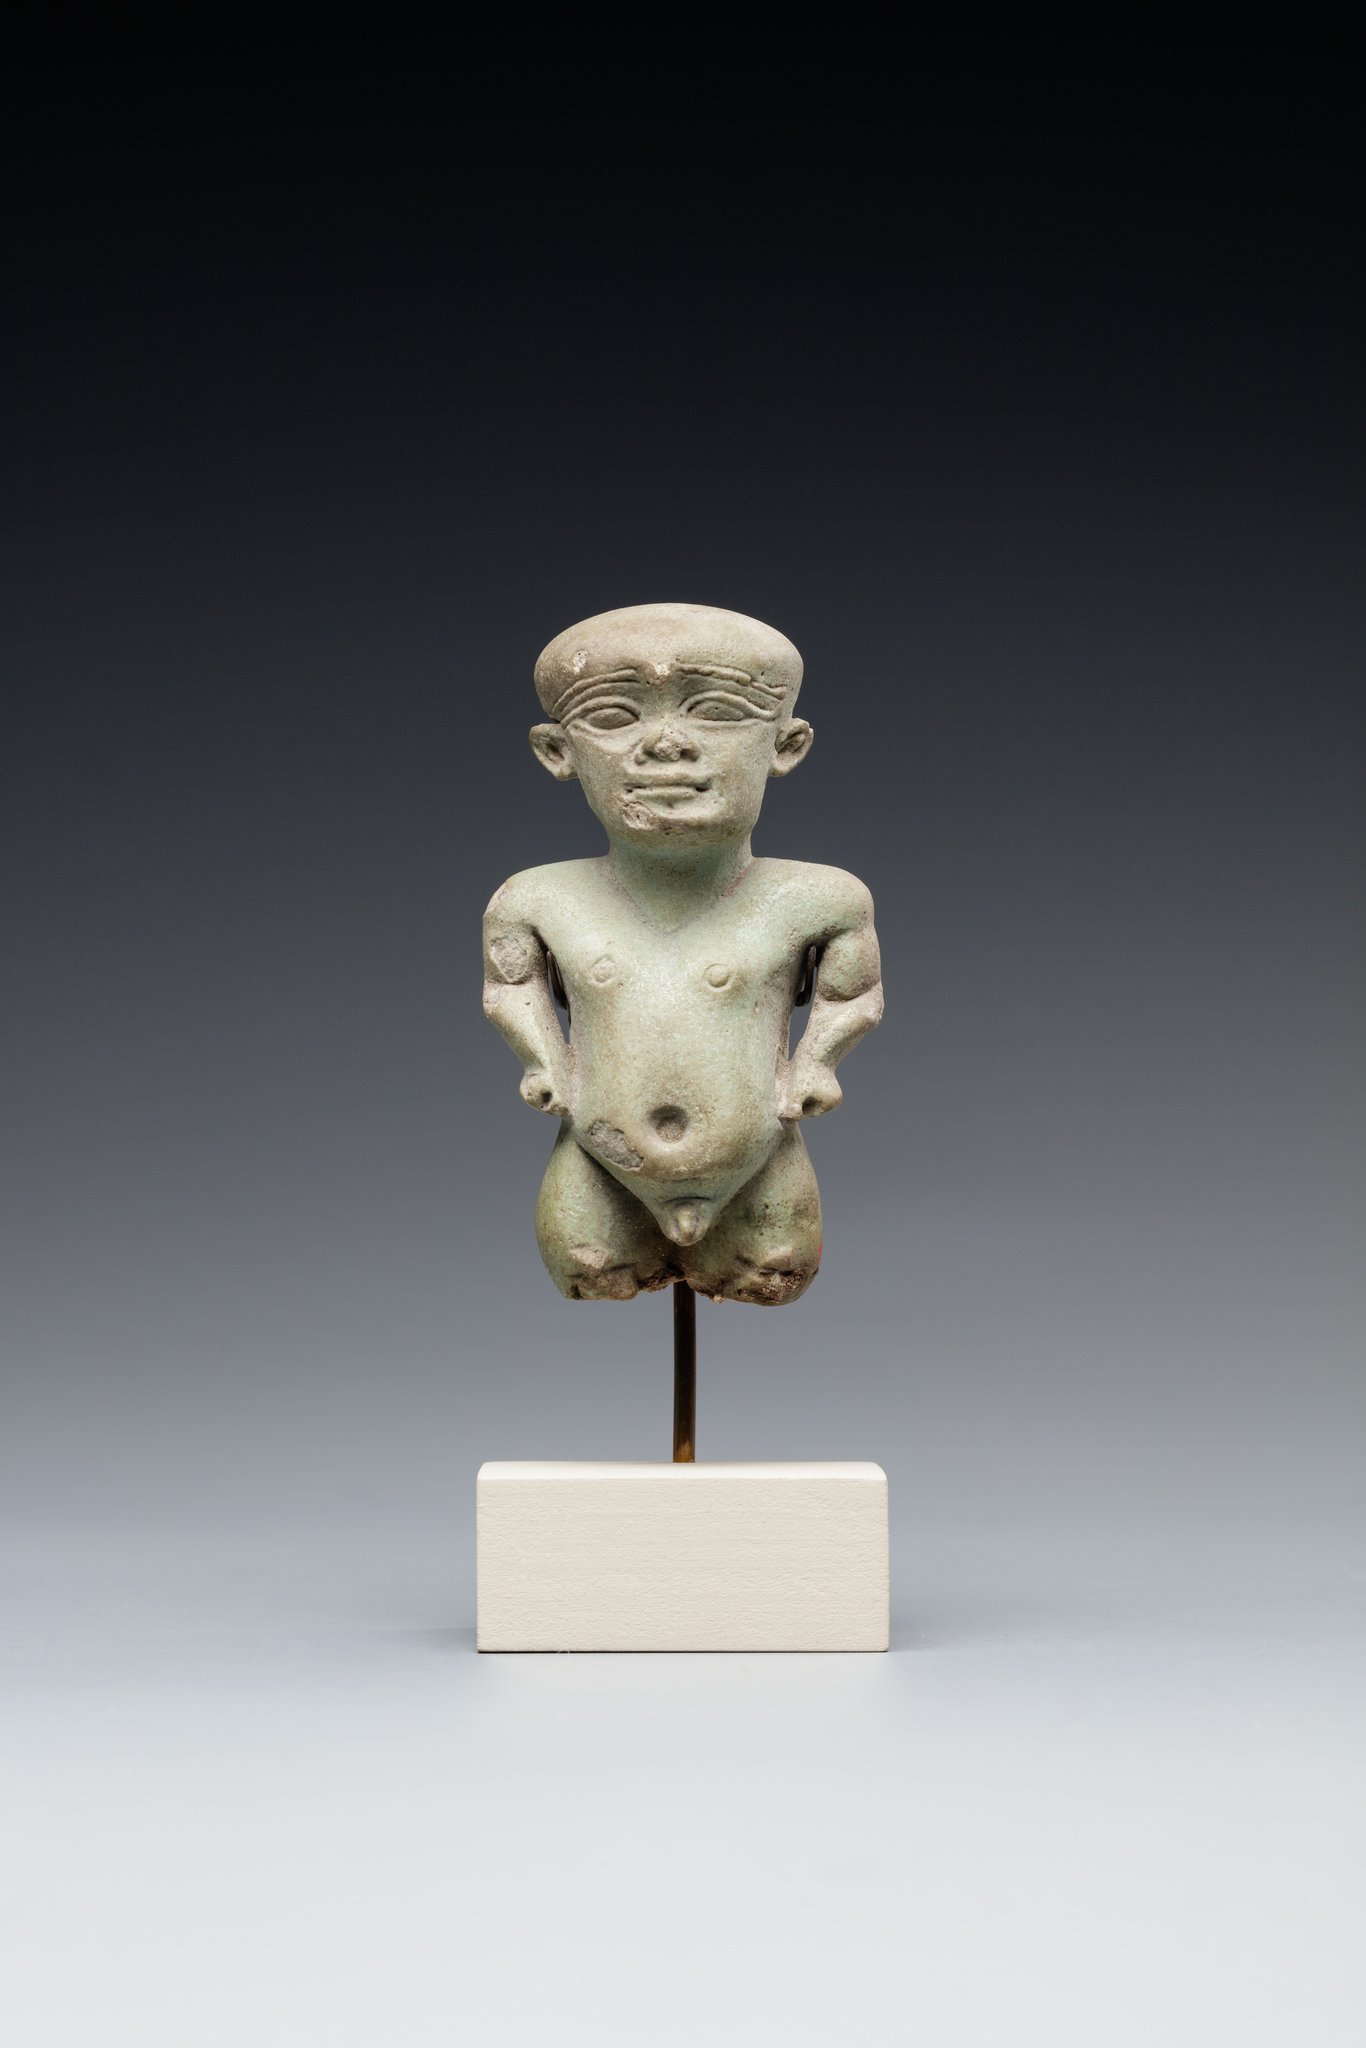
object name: amulet, pataikos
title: Pataikos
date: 664-630 BCE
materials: faience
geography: egypt